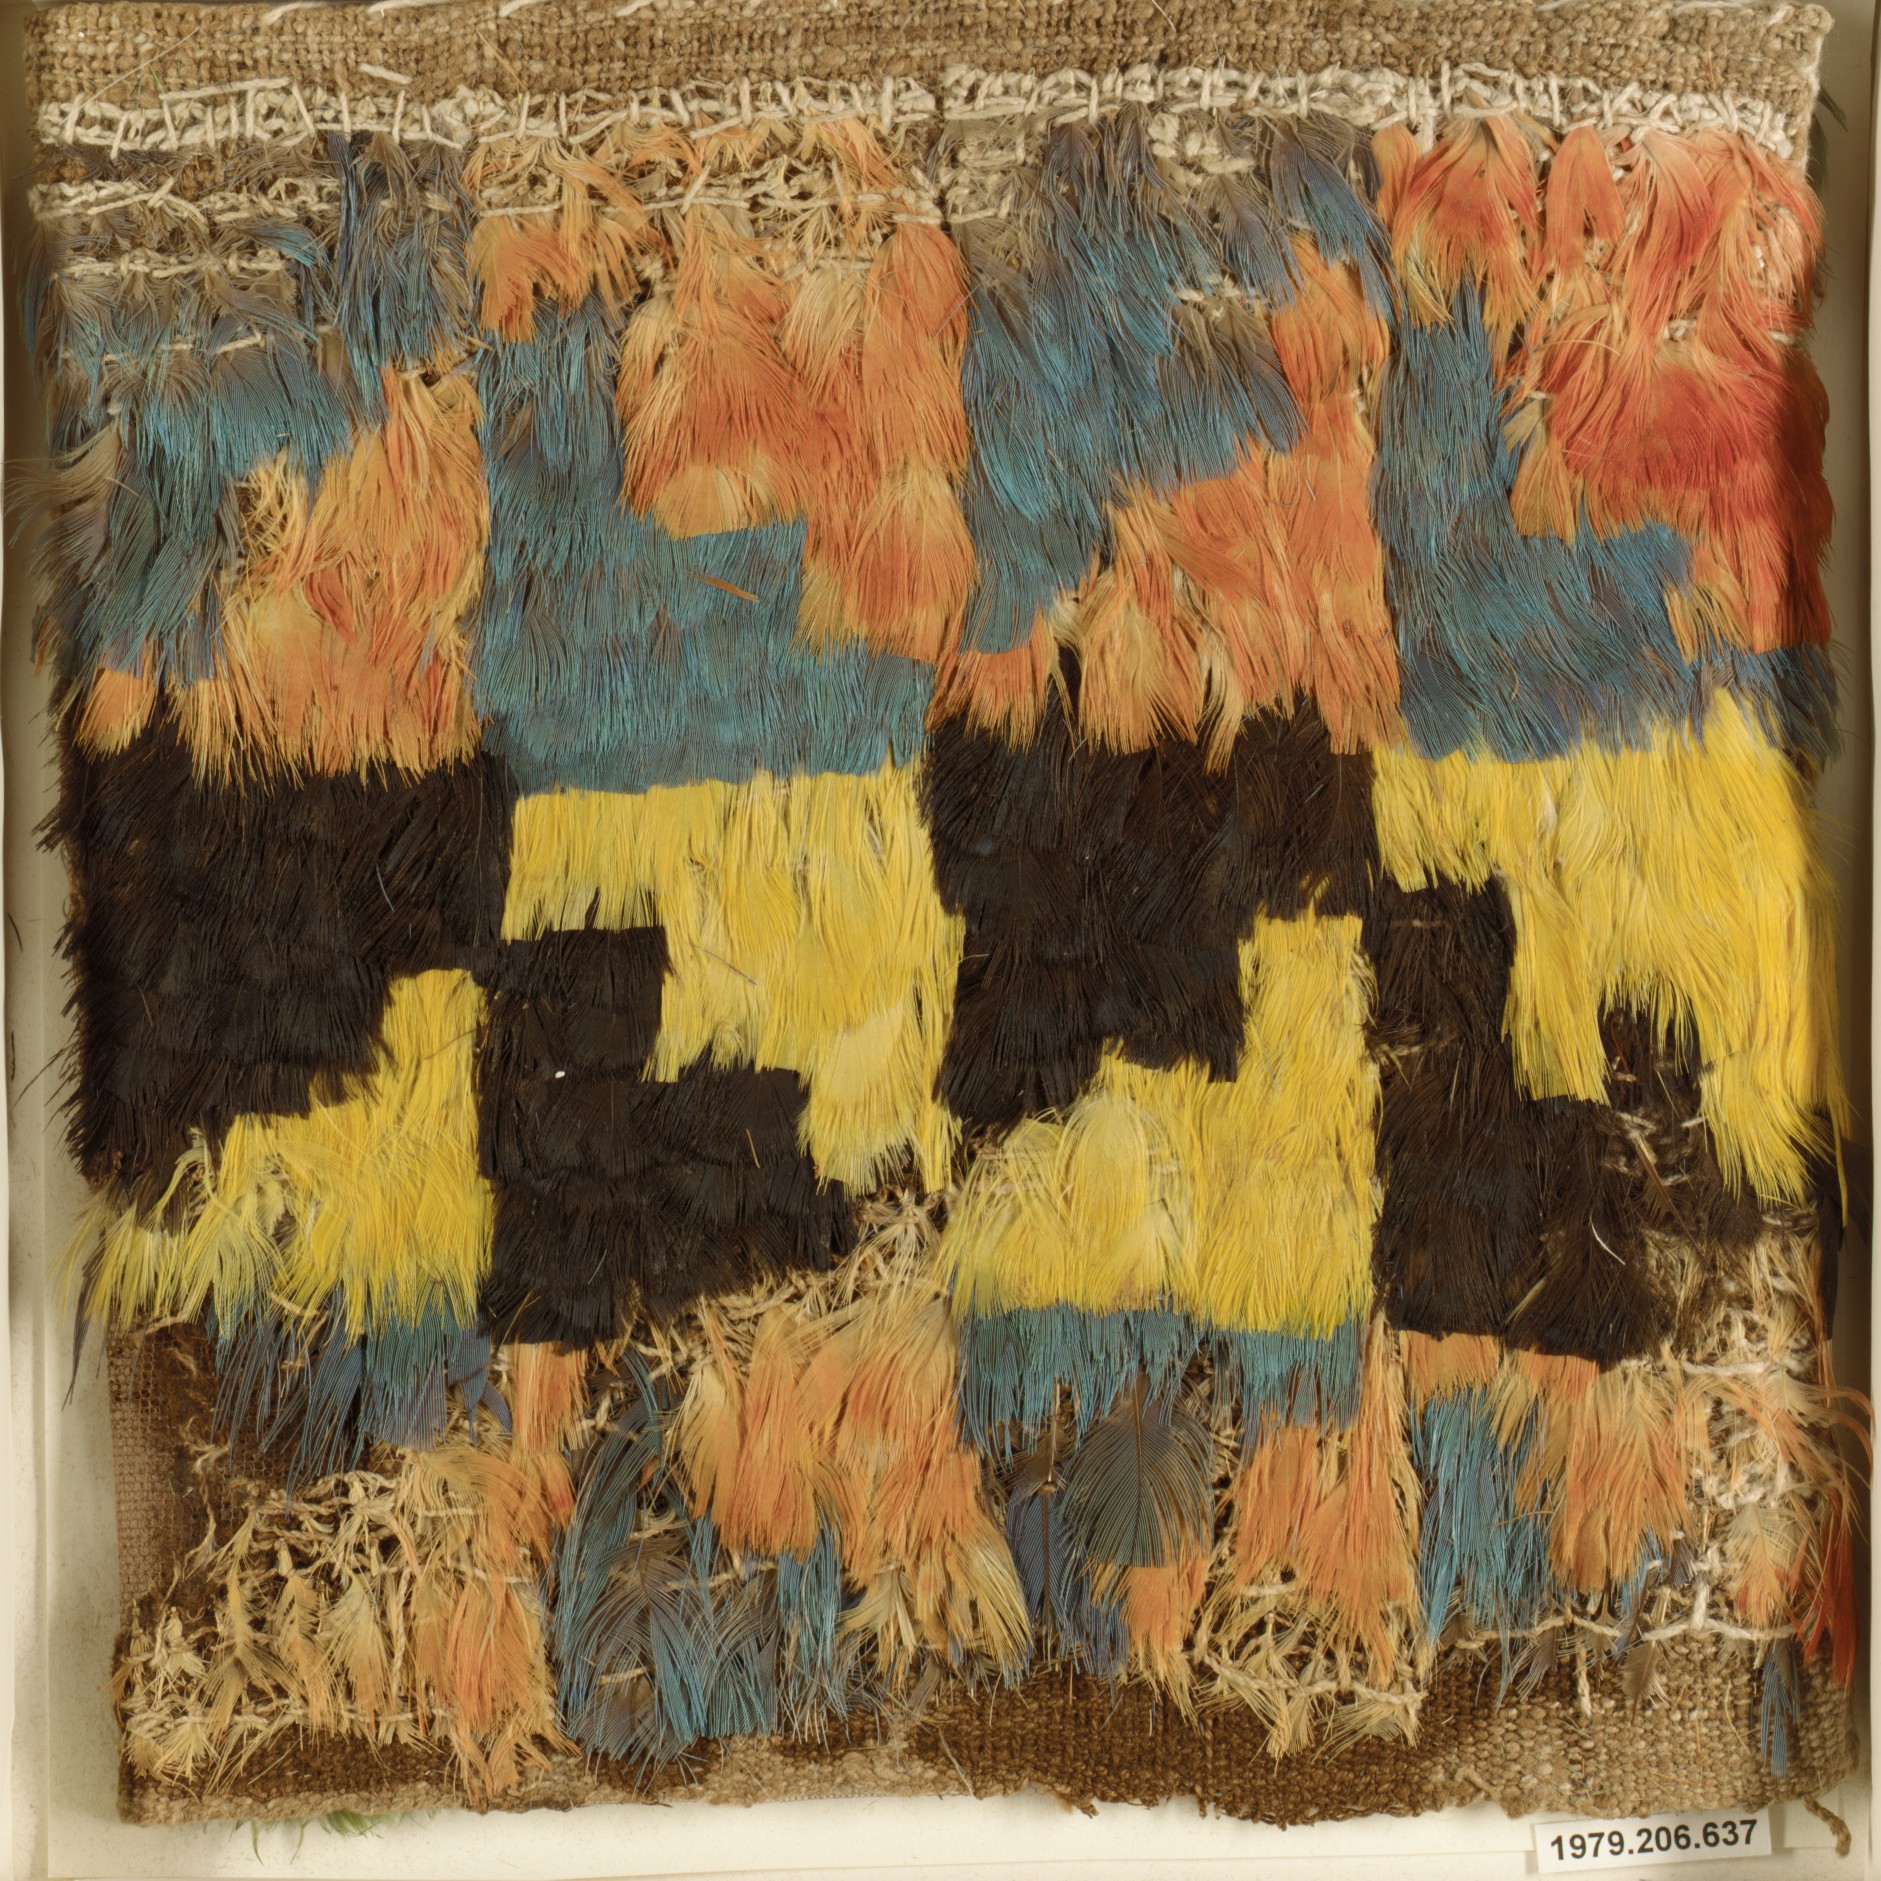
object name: miniature dress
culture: ica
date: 1101-1300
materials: cotton, feather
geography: peru